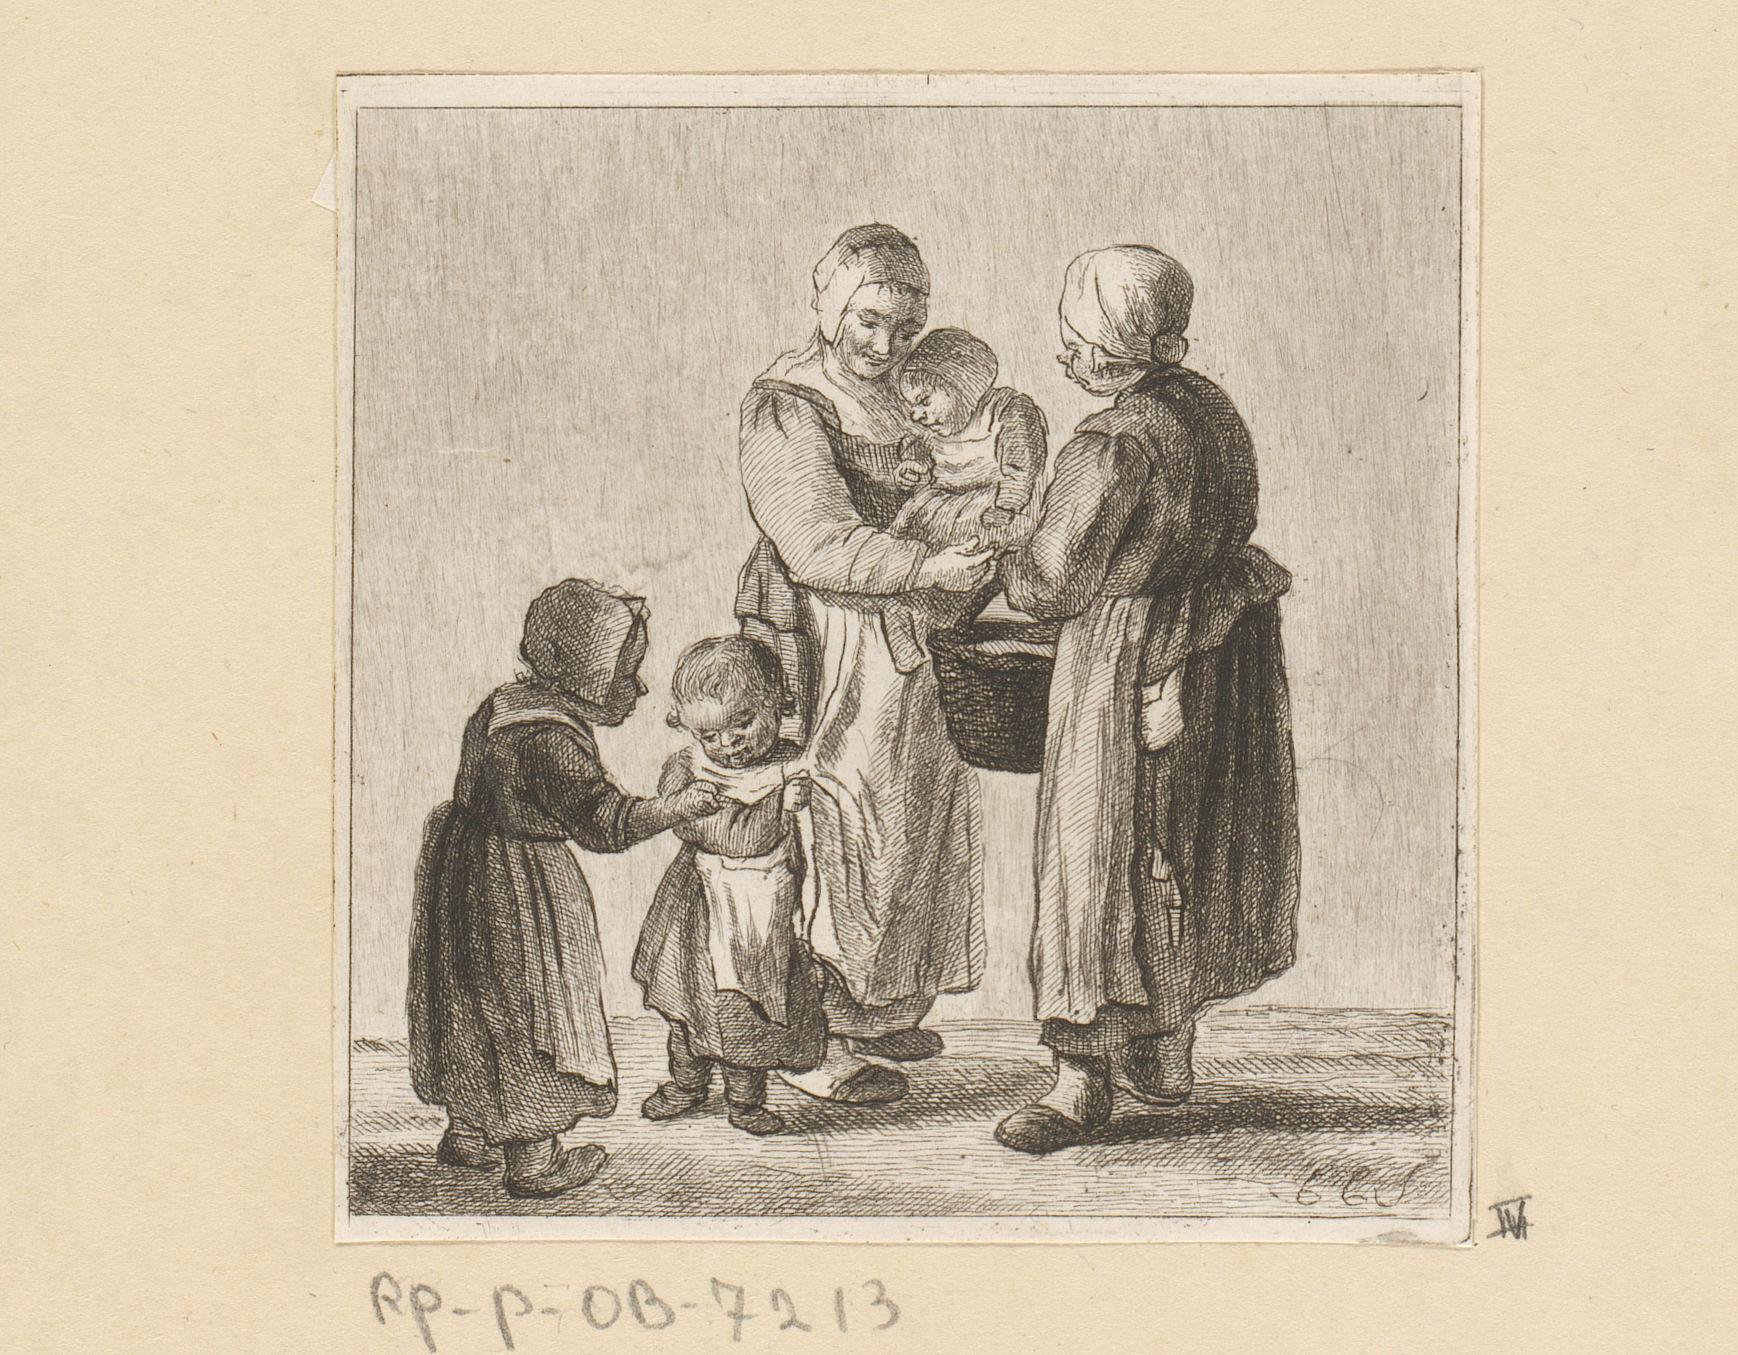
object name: print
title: Twee moeders met kinderen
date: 1779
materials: paper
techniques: etching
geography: leiden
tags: mother and baby or young child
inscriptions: collector's mark: Lugt 2228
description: Twee moeders praten met elkaar. De een draagt een baby op de arm. Haar ander dochtertje houdt verlegen haar rokken vast. De tweede moeder overhandigt de eerste een mand. Haar dochtertje probeert contact te zoeken met haar leeftijdsgenootje.